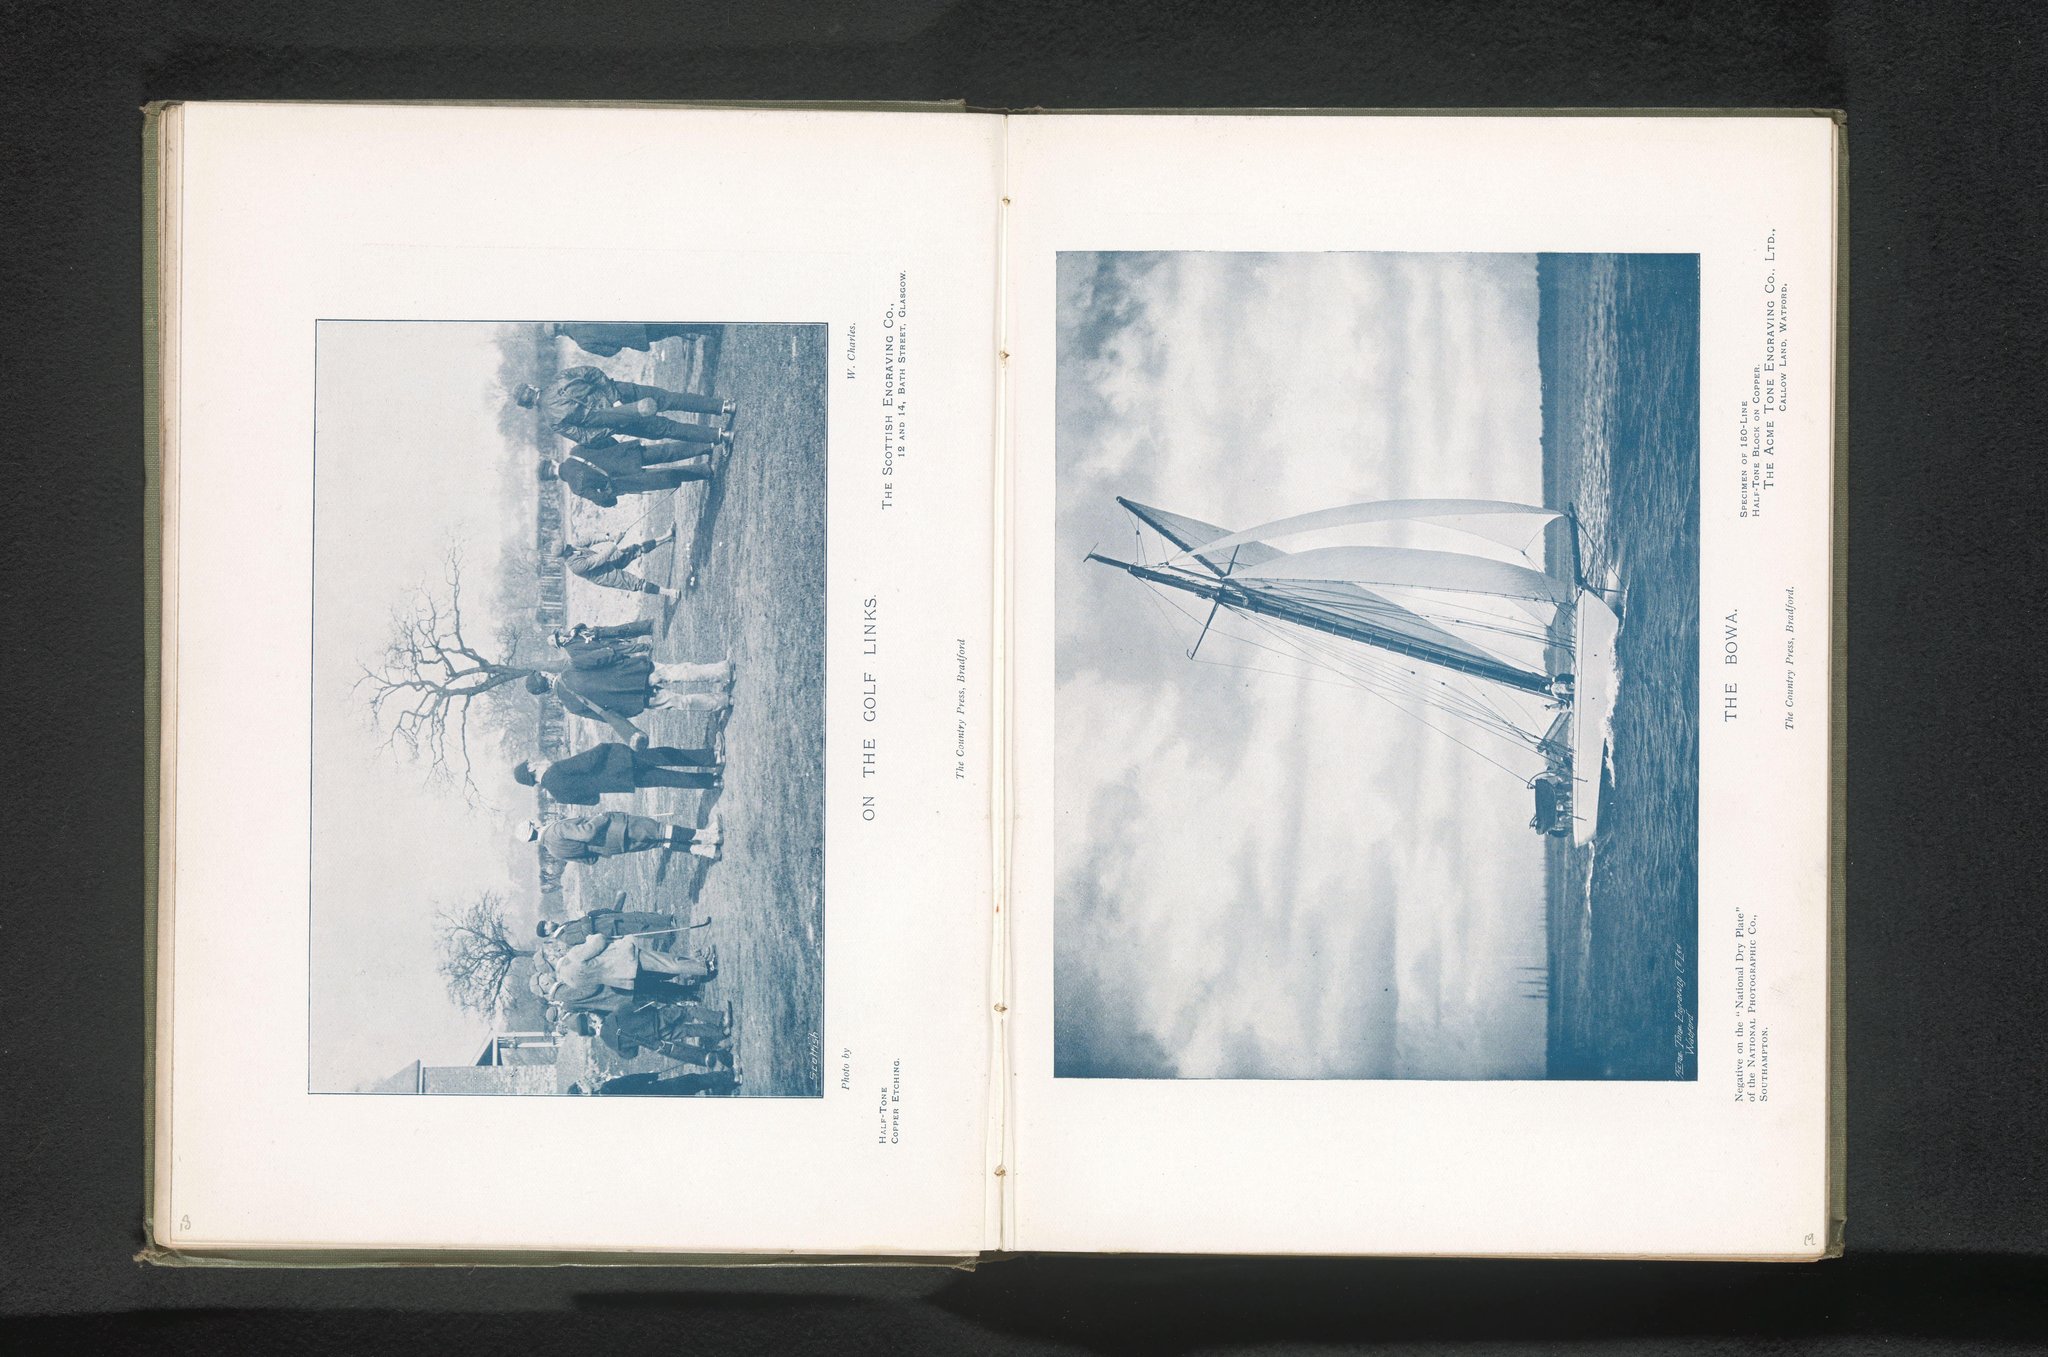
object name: photomechanical print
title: Zeilboot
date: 1893-1898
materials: paper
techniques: autotype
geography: watford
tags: sailing-ship, sailing-boat (+ four persons or more ~ traffic and transport)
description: Prent op vijfde ongenummerde pagina na pagina 16.